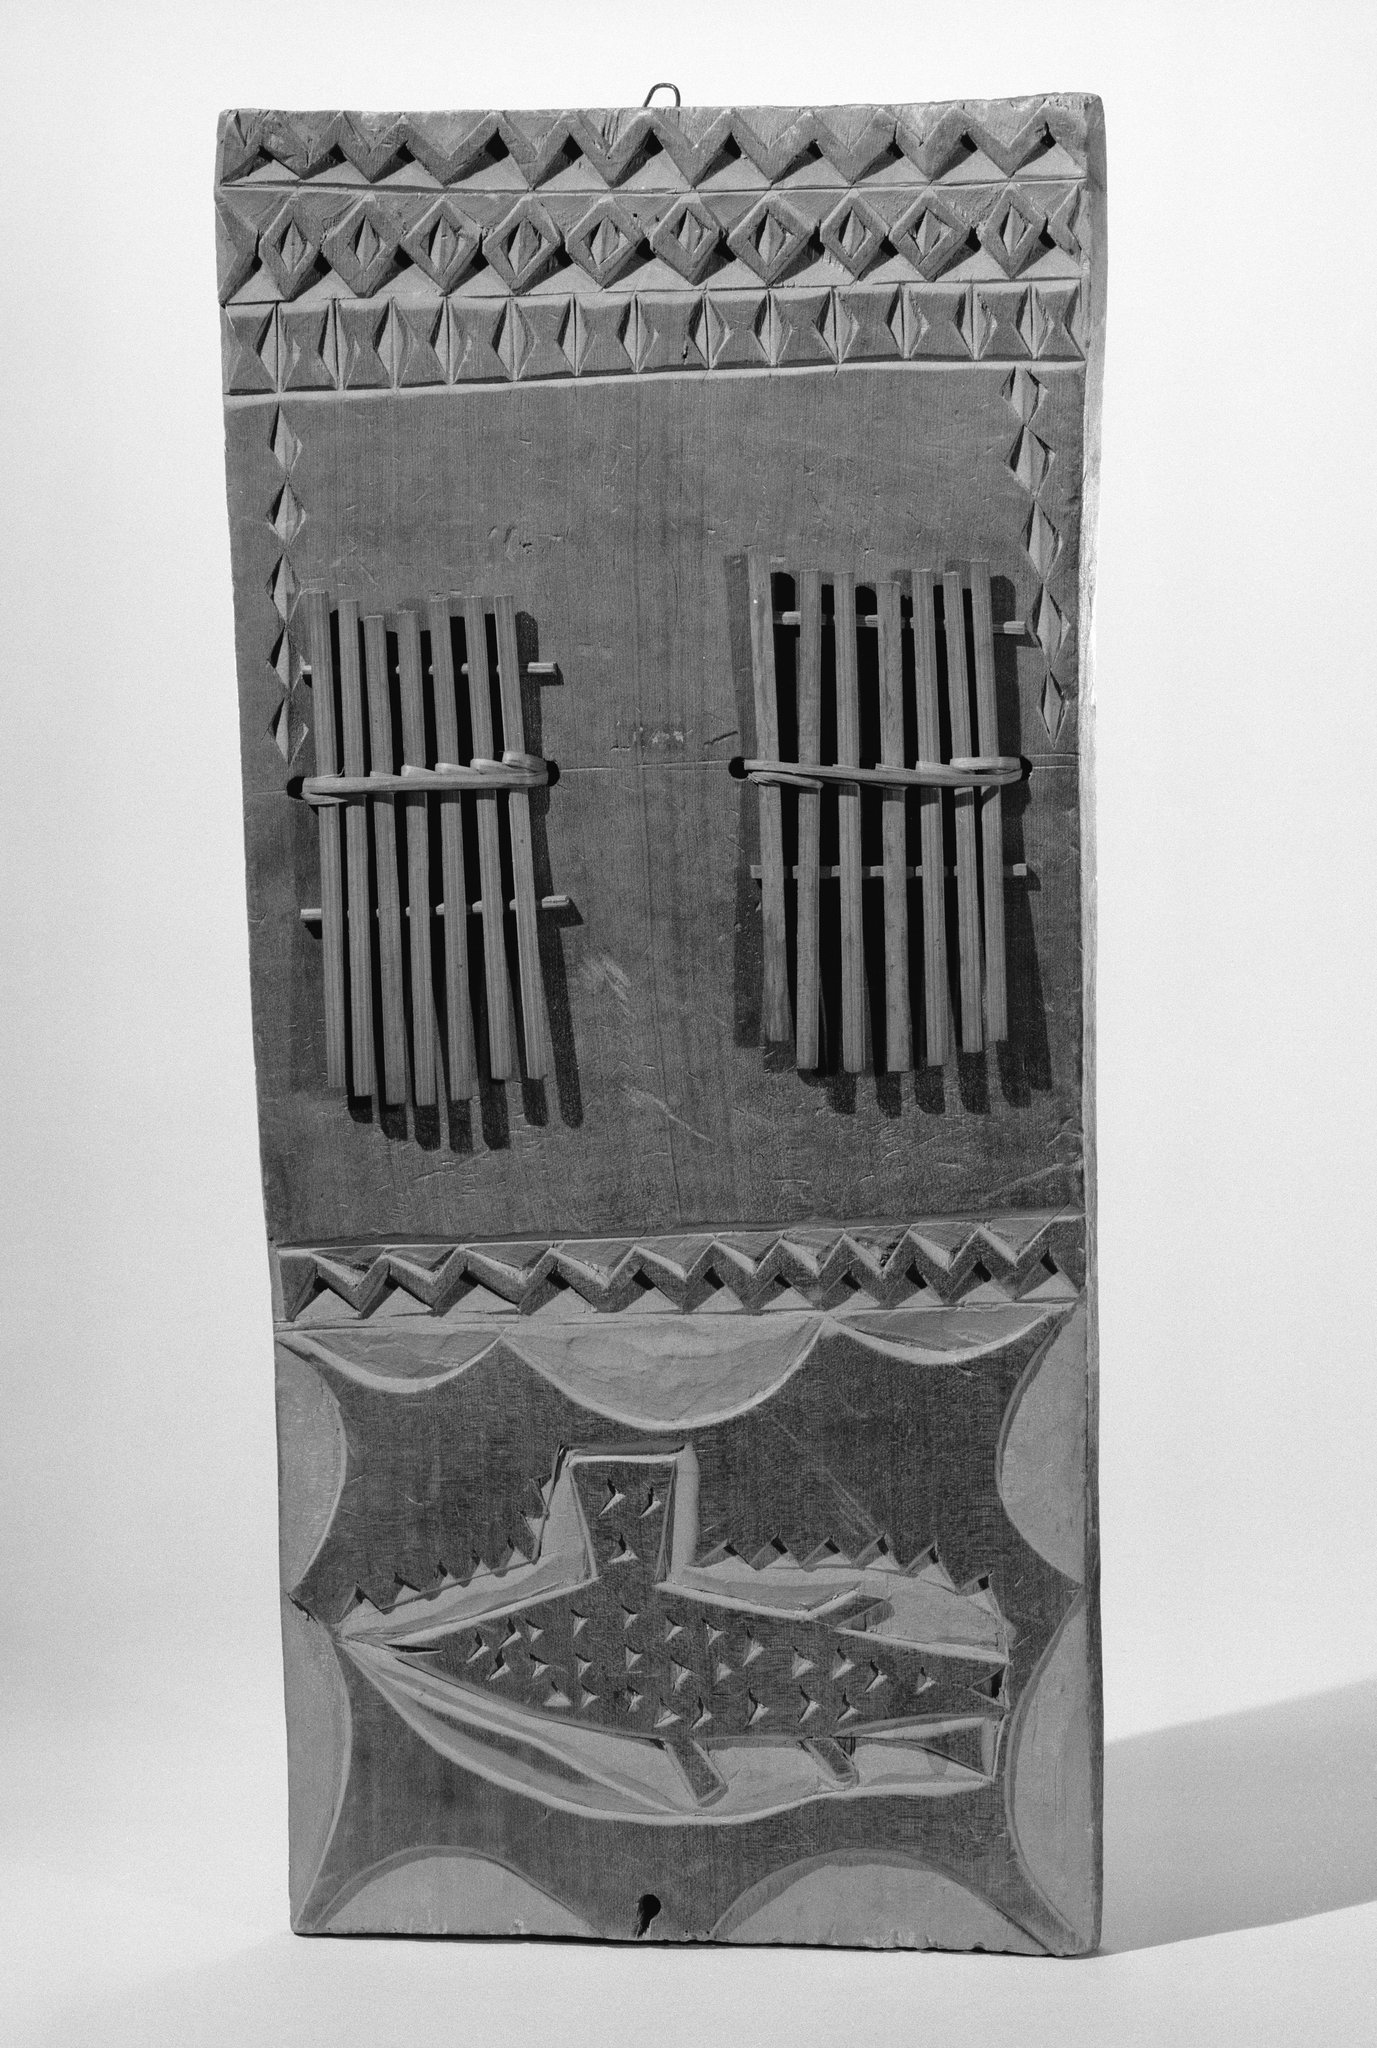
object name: zanze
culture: cameroonian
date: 1867-1900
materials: wood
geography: cameroon